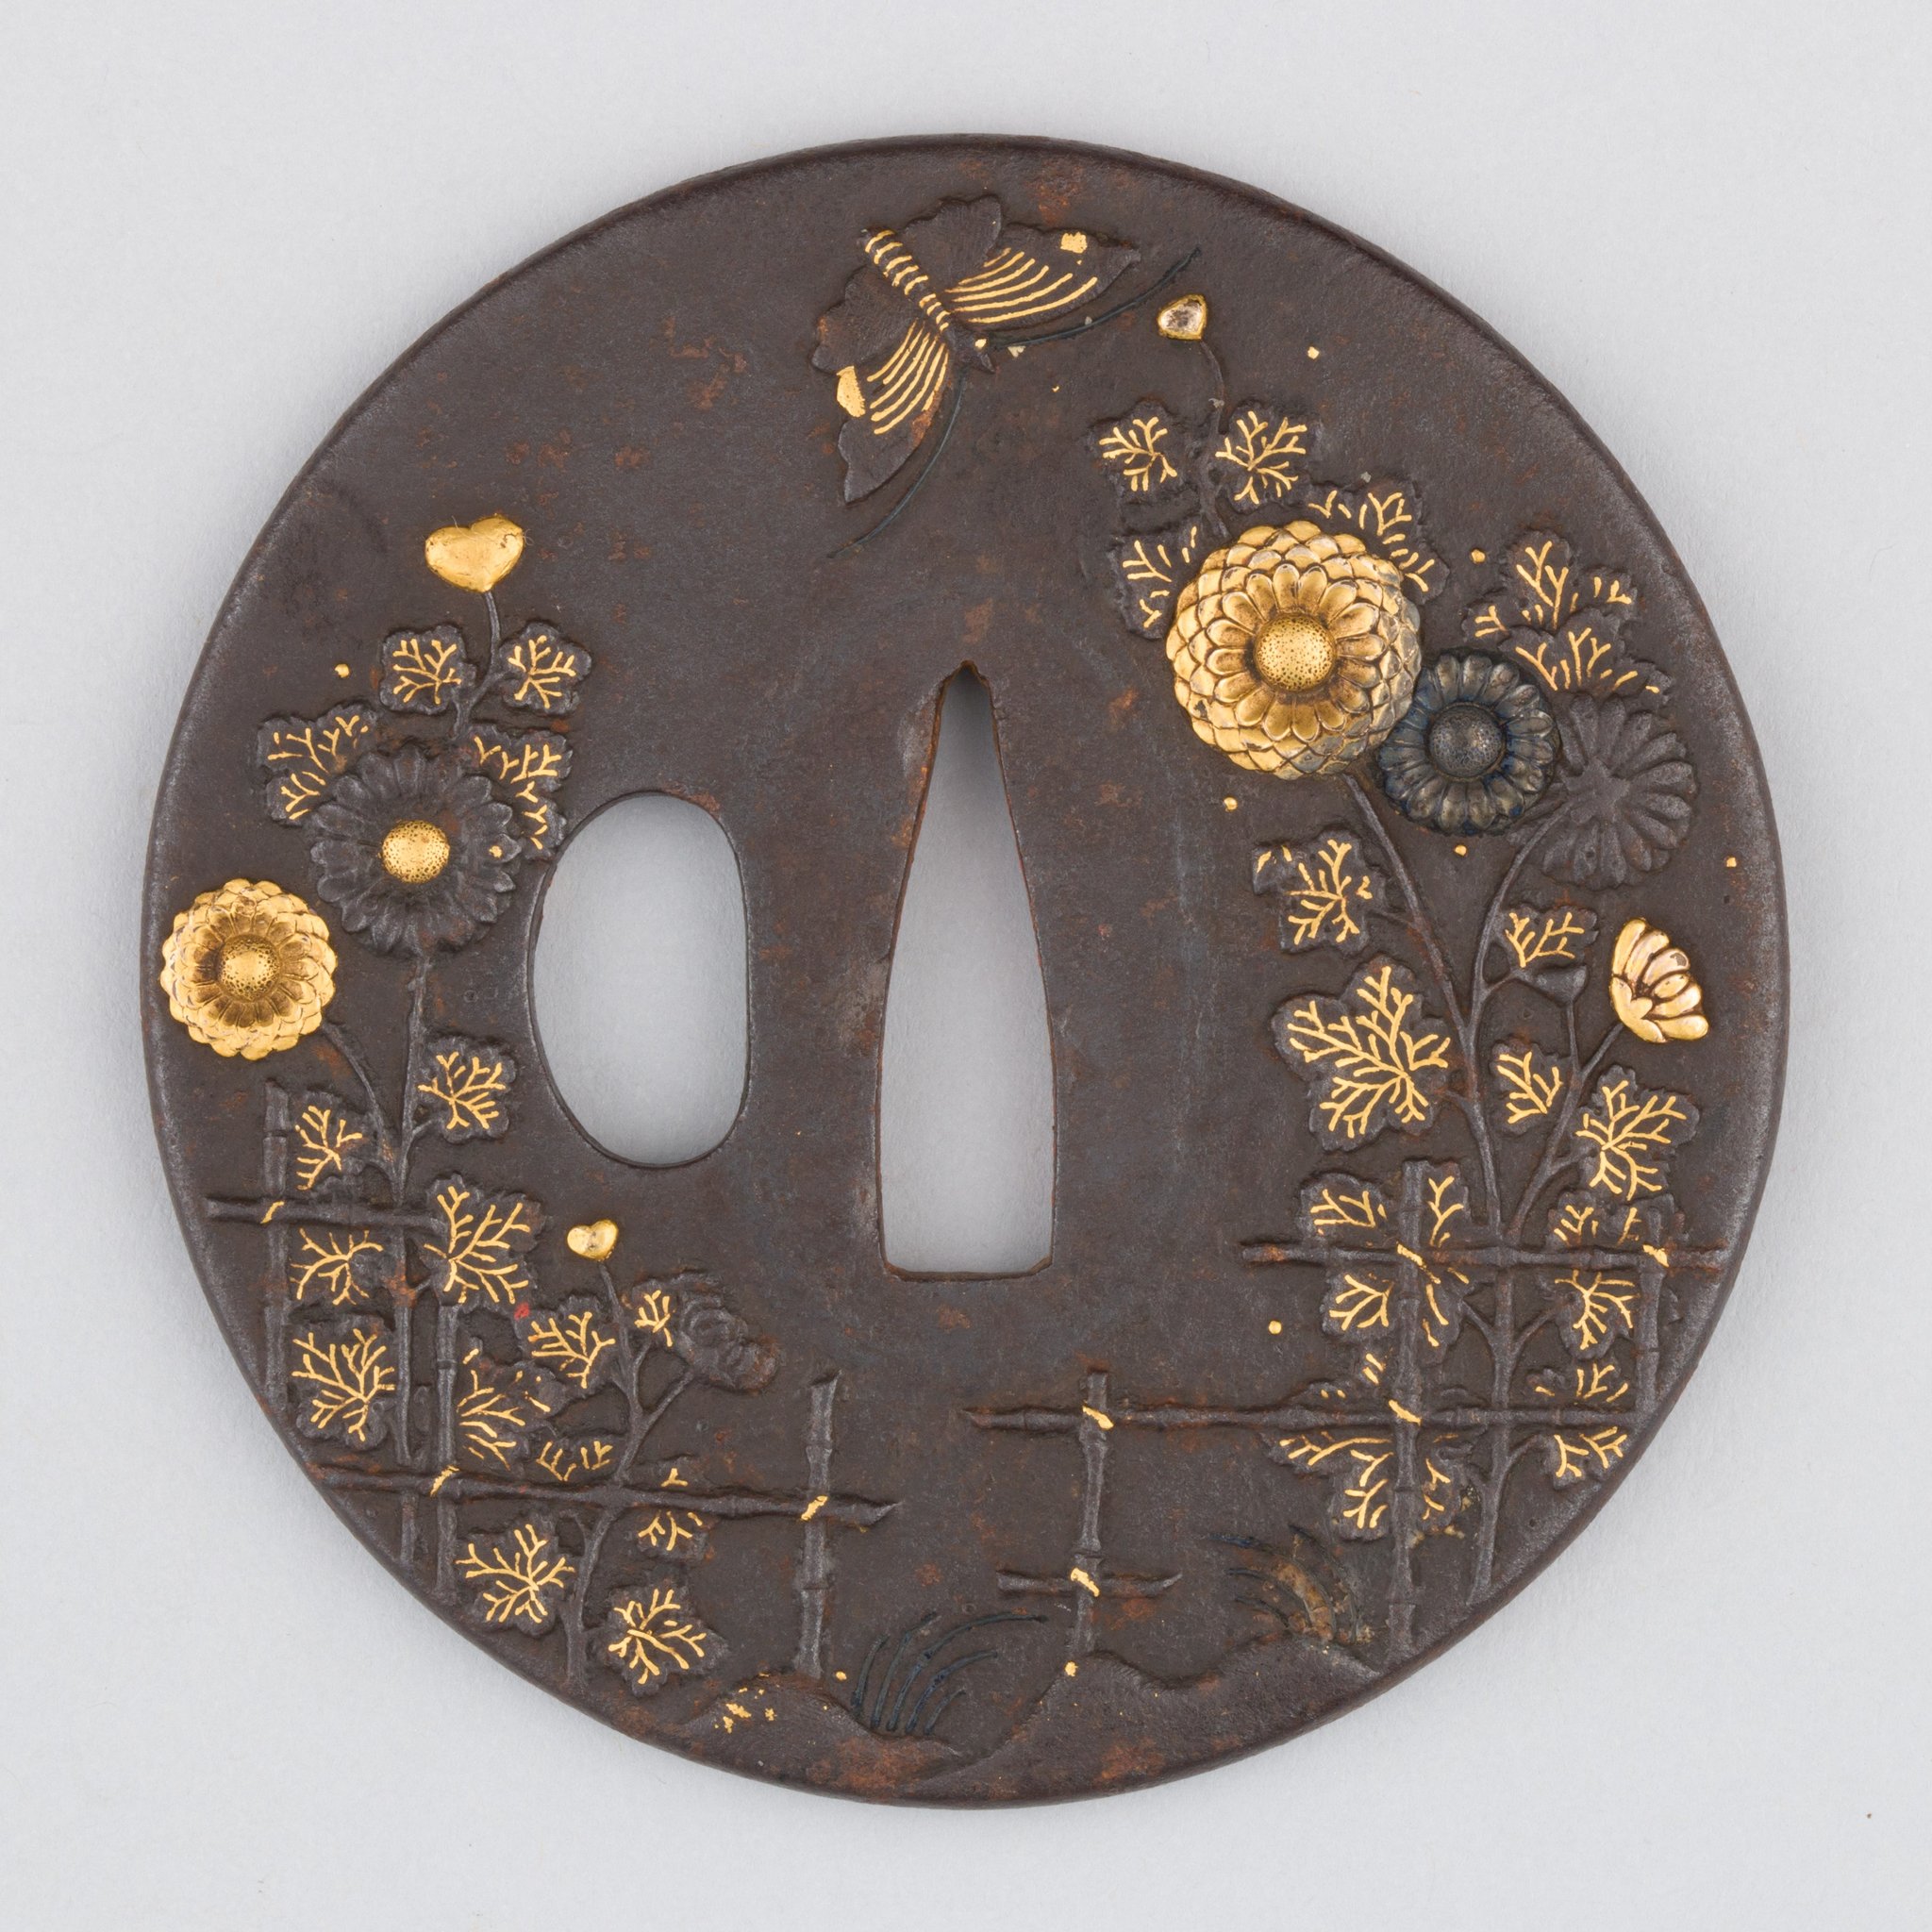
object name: sword guard tsuba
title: Sword Guard (Tsuba)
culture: japanese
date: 1615-1868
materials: copper, gold, iron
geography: japan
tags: butterflies,flowers